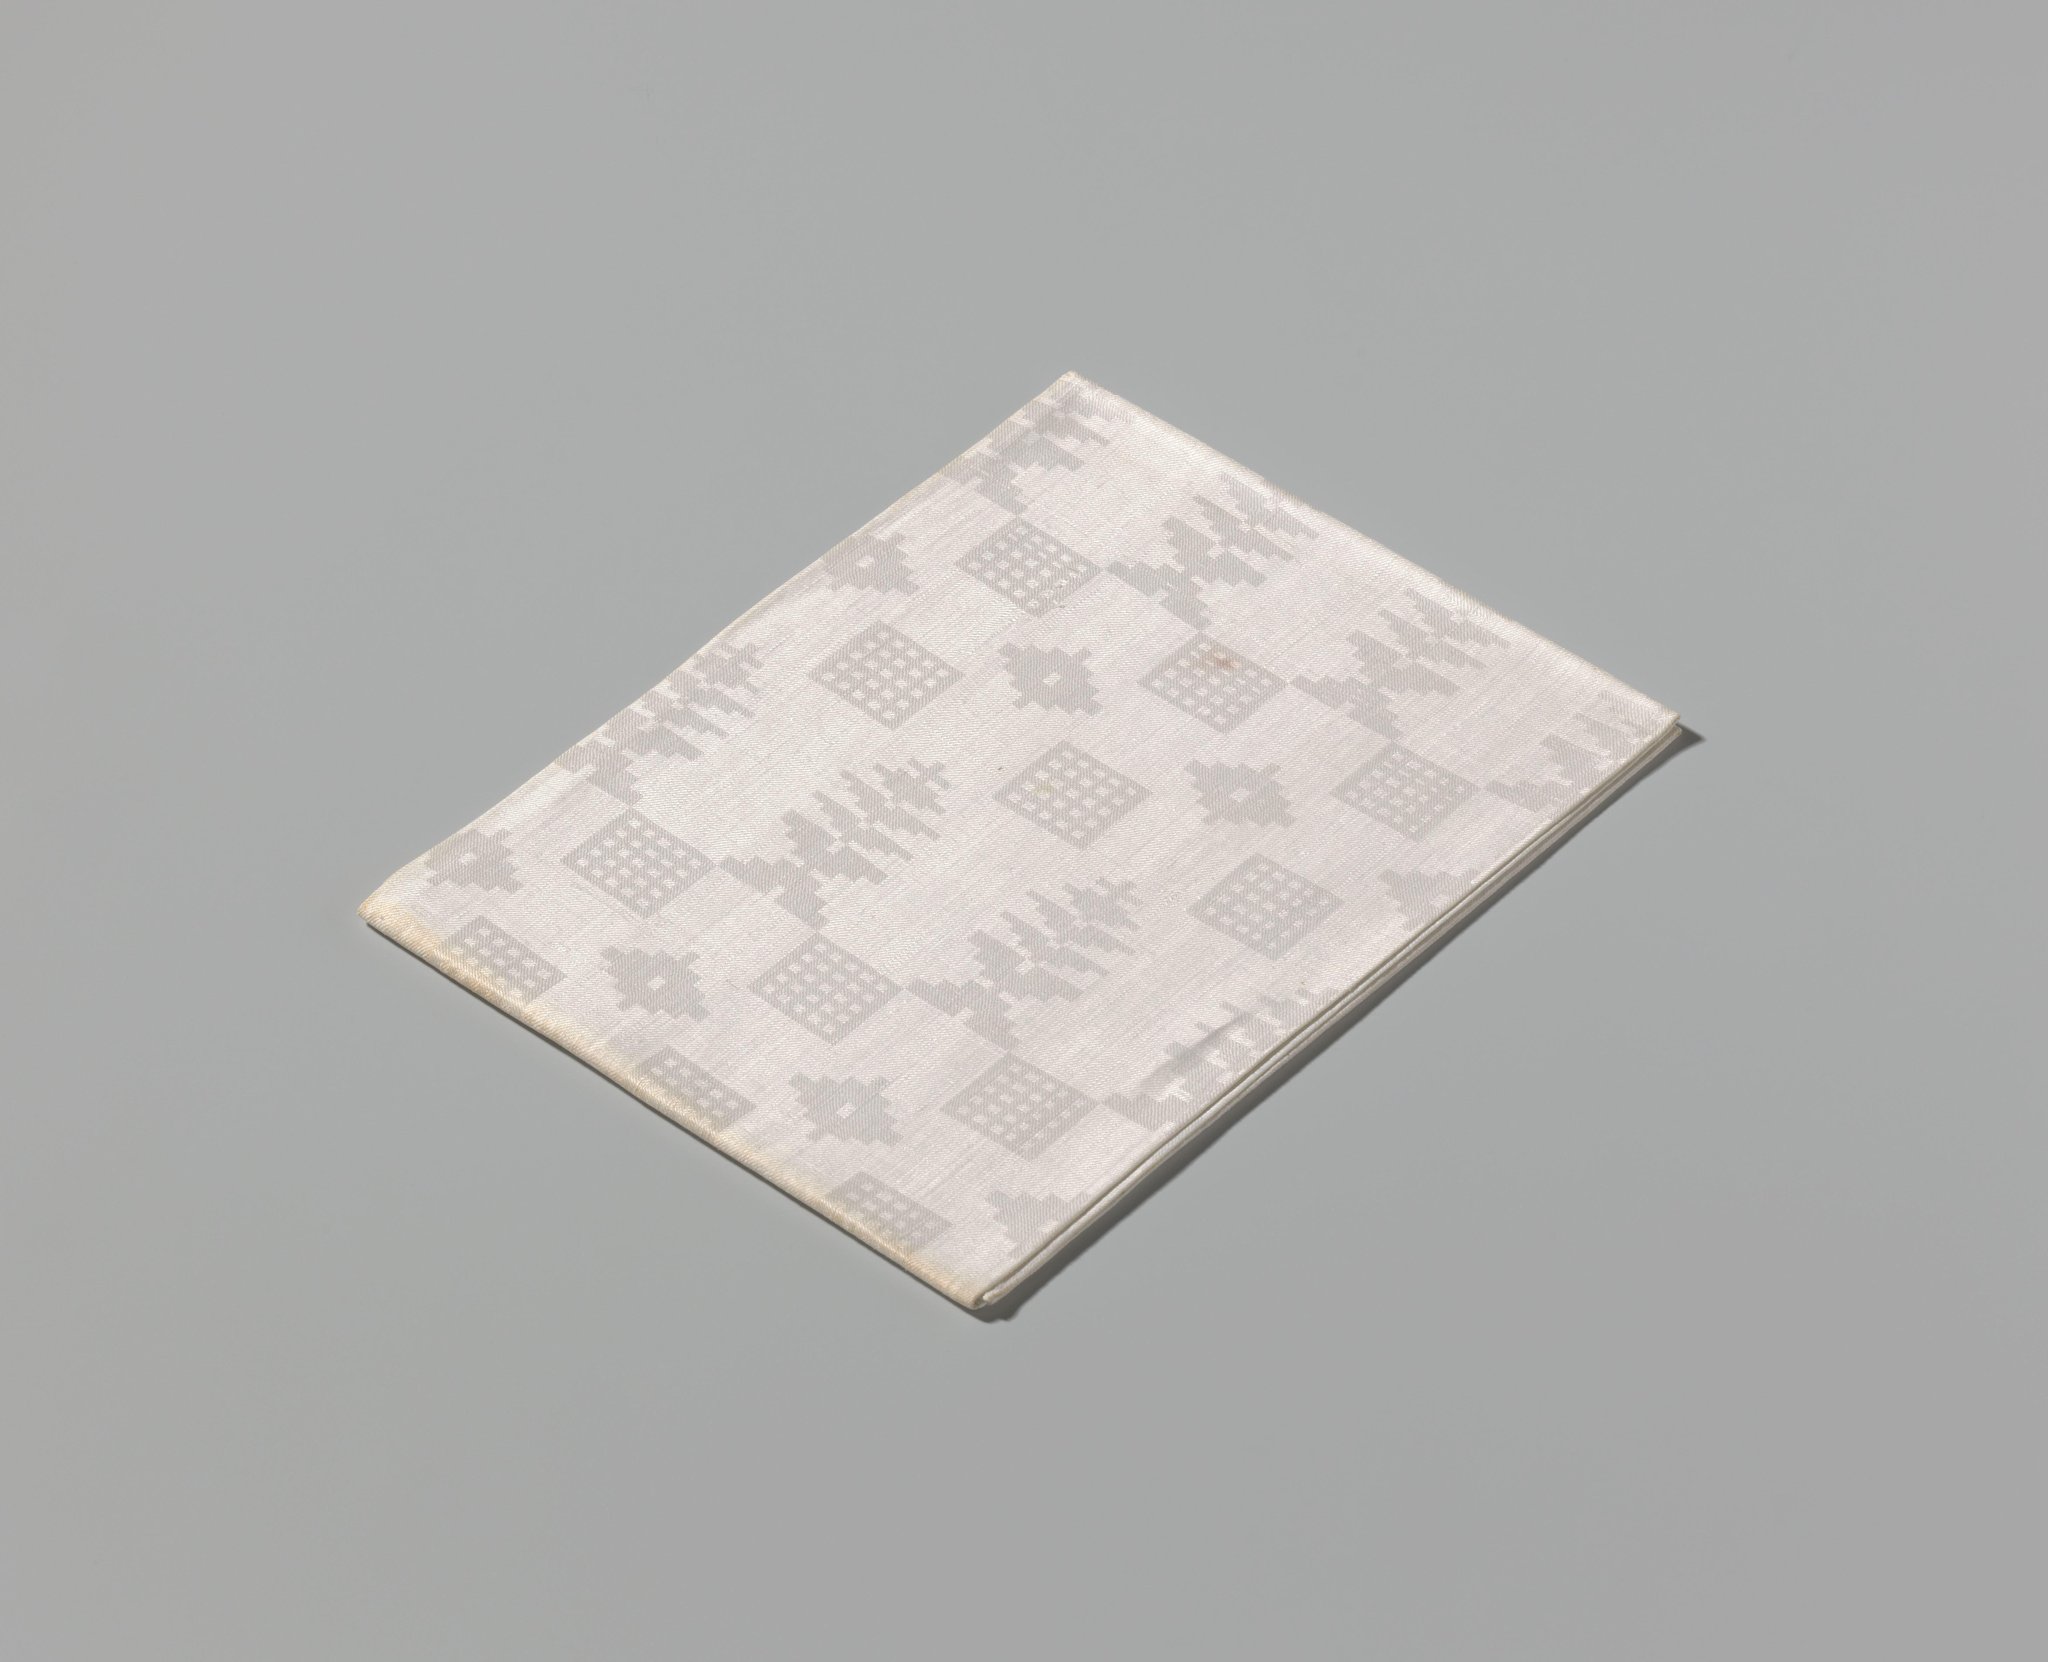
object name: napkin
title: Servet van linnen met pellenpatroon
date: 1730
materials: linen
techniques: twill, peeled fabric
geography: northern netherlands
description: wit linnen servet met pellen patroon, merk kroon WG 42 en 1730